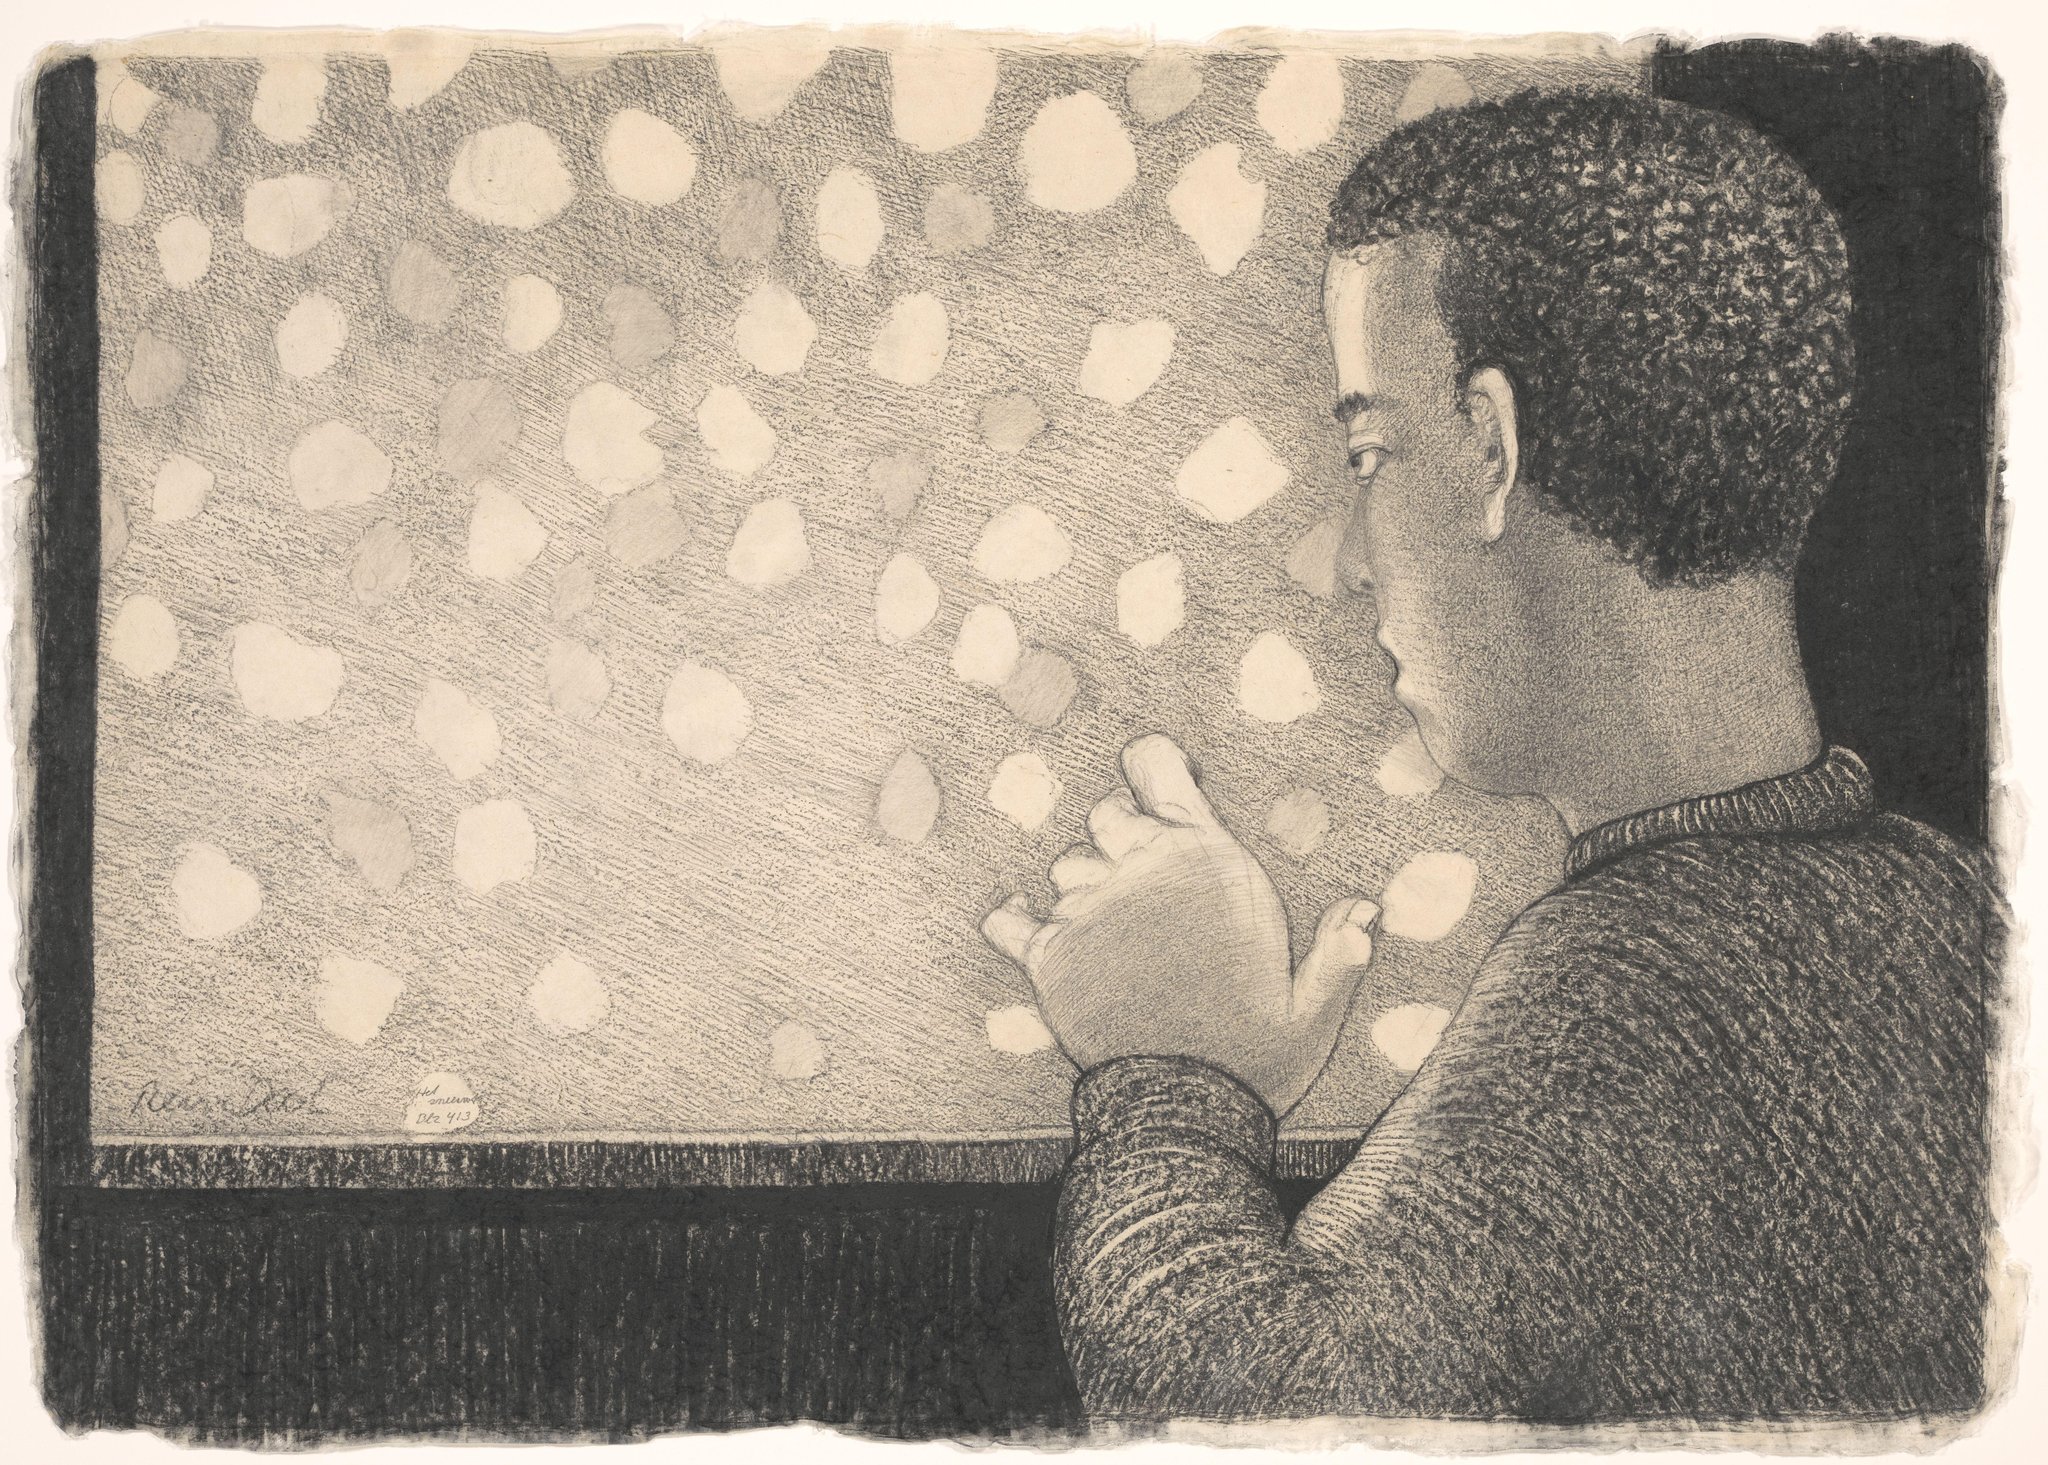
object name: drawing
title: Het sneeuwt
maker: rein dool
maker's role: draughtsman, painter, print maker, sculptor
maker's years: 1933-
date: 2013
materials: charcoal, paper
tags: amsterdam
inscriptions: signature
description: Hans Faverey kijkend naar sneeuw, uit de reeks tekeningen geïnspireerd op gedichten van Hans Faverey (vergelijk: Verzameld Werk p. 413).